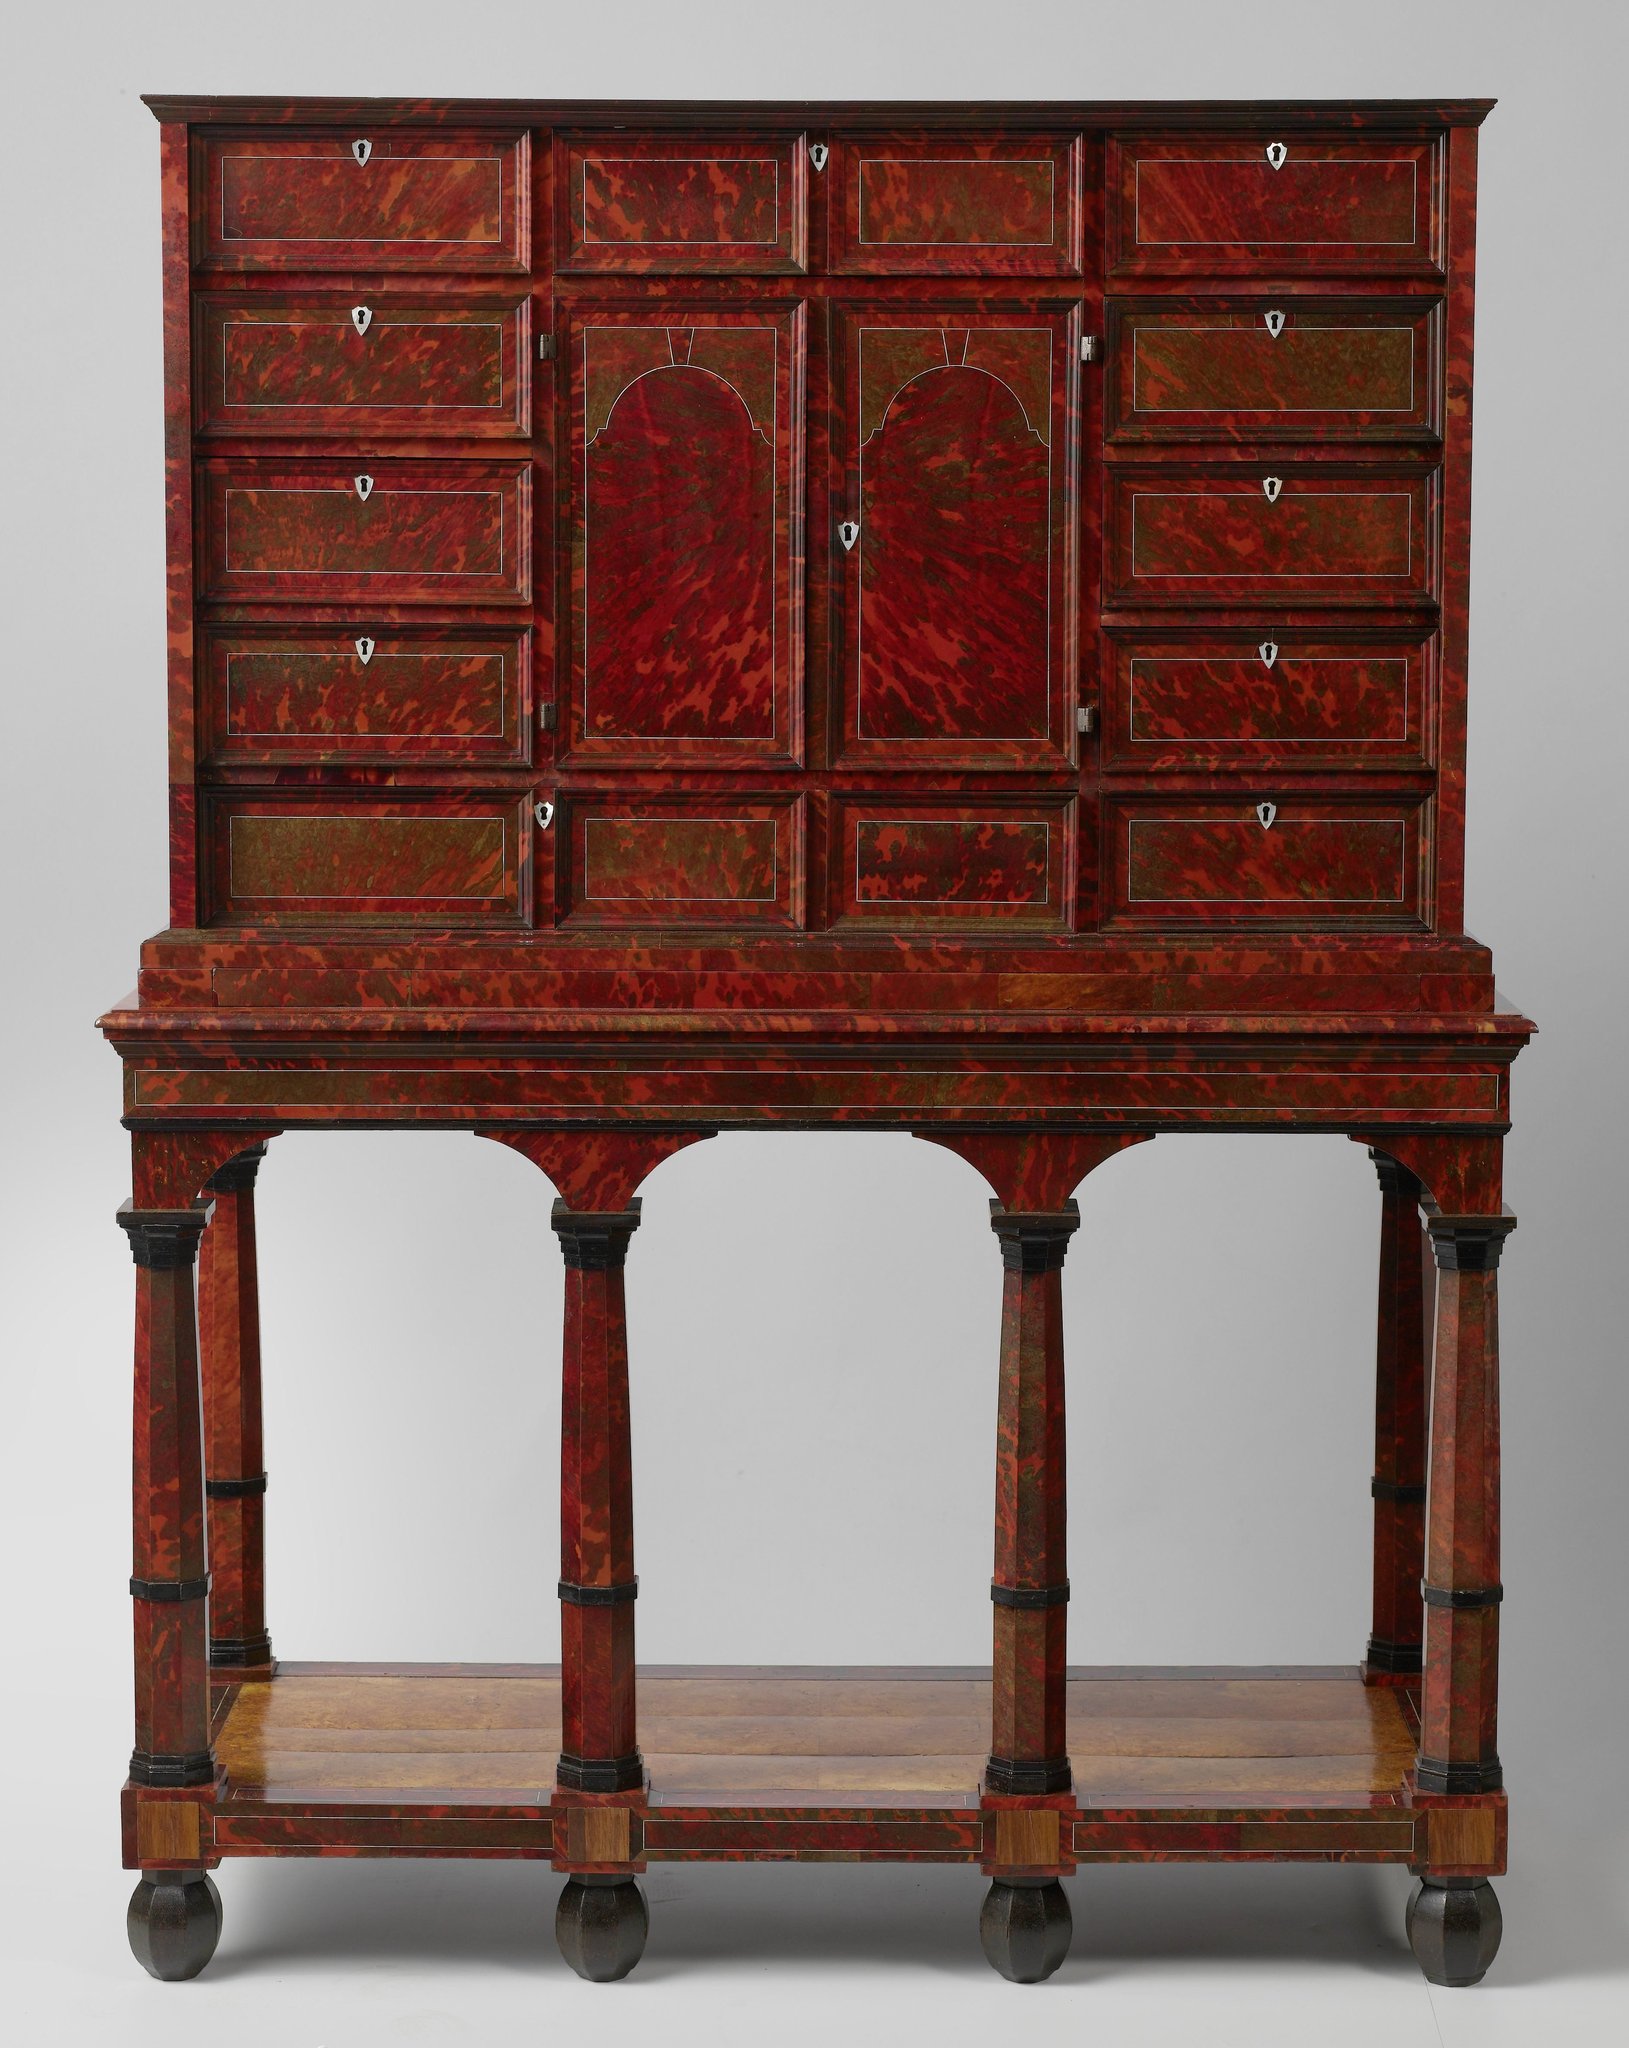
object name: furniture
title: Cabinet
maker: Anonymous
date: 1655-1660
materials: bone, wood, glass, ivory, silver, shell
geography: antwerp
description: Around 1650, Antwerp was the leading centre of production for cabinets. They were made in large numbers and exported to many European countries. In general, they were richly and strikingly ornamented. This cabinet is notable for its simplicity. It is almost entirely veneered with expensive tortoiseshell and inlaid with decorative lines of bone. It may have been intended for the Paris market.